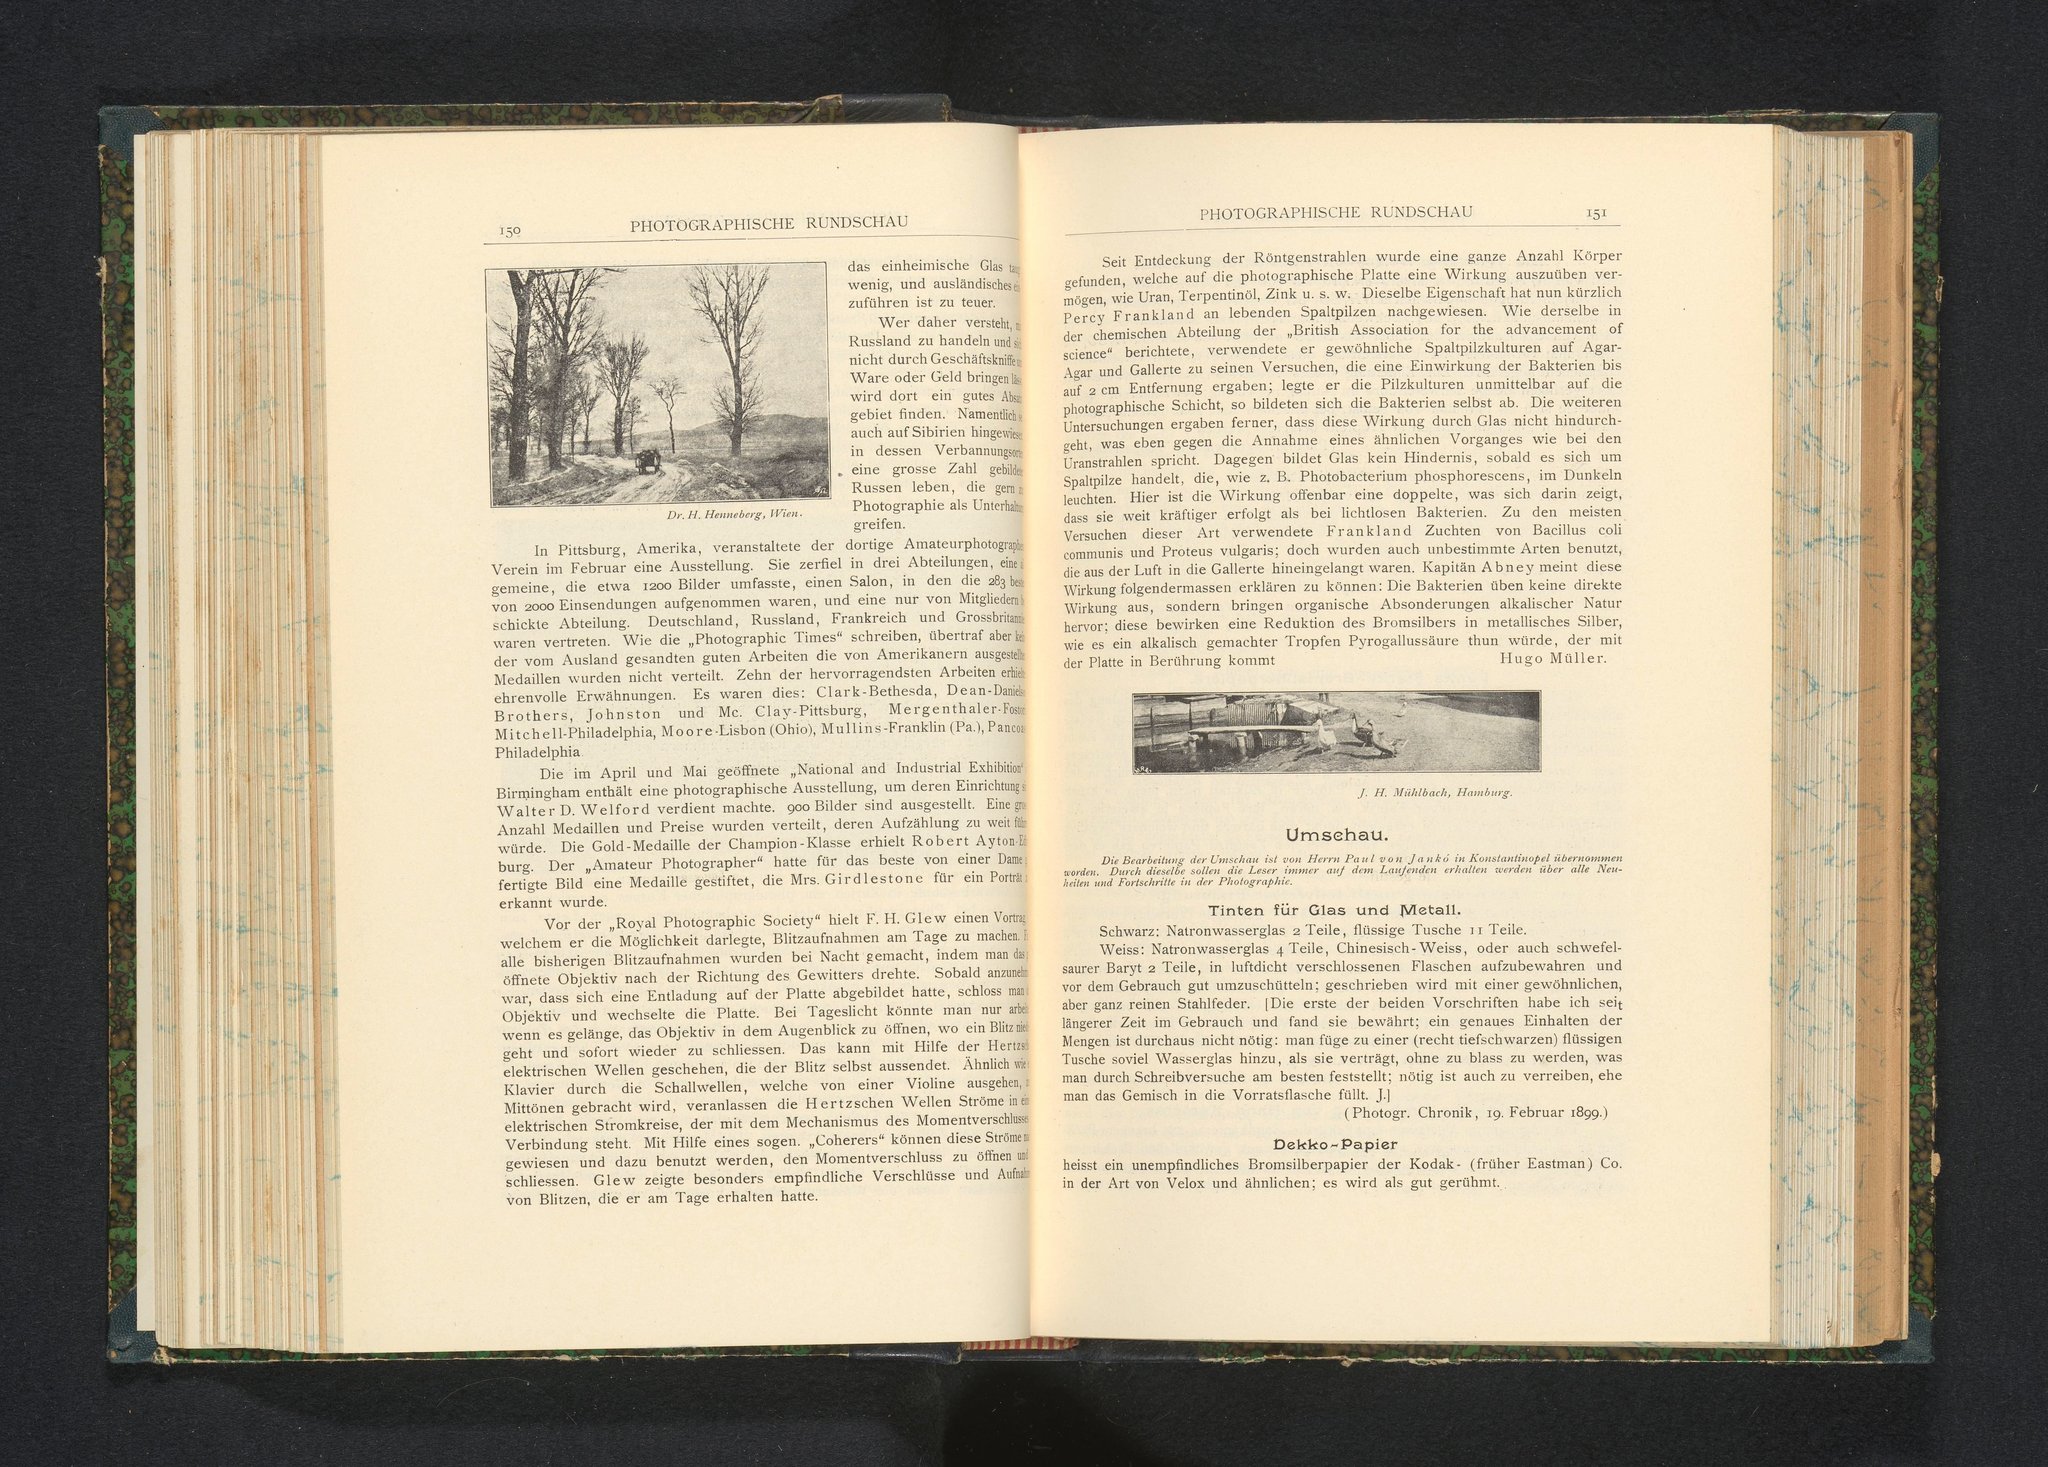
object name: photomechanical print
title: Drie eenden bij een sloot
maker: j.h. mühlbach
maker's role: fotograaf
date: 1894-1899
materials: paper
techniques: autotype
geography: berlin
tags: small canal, ditch, water-birds: duck